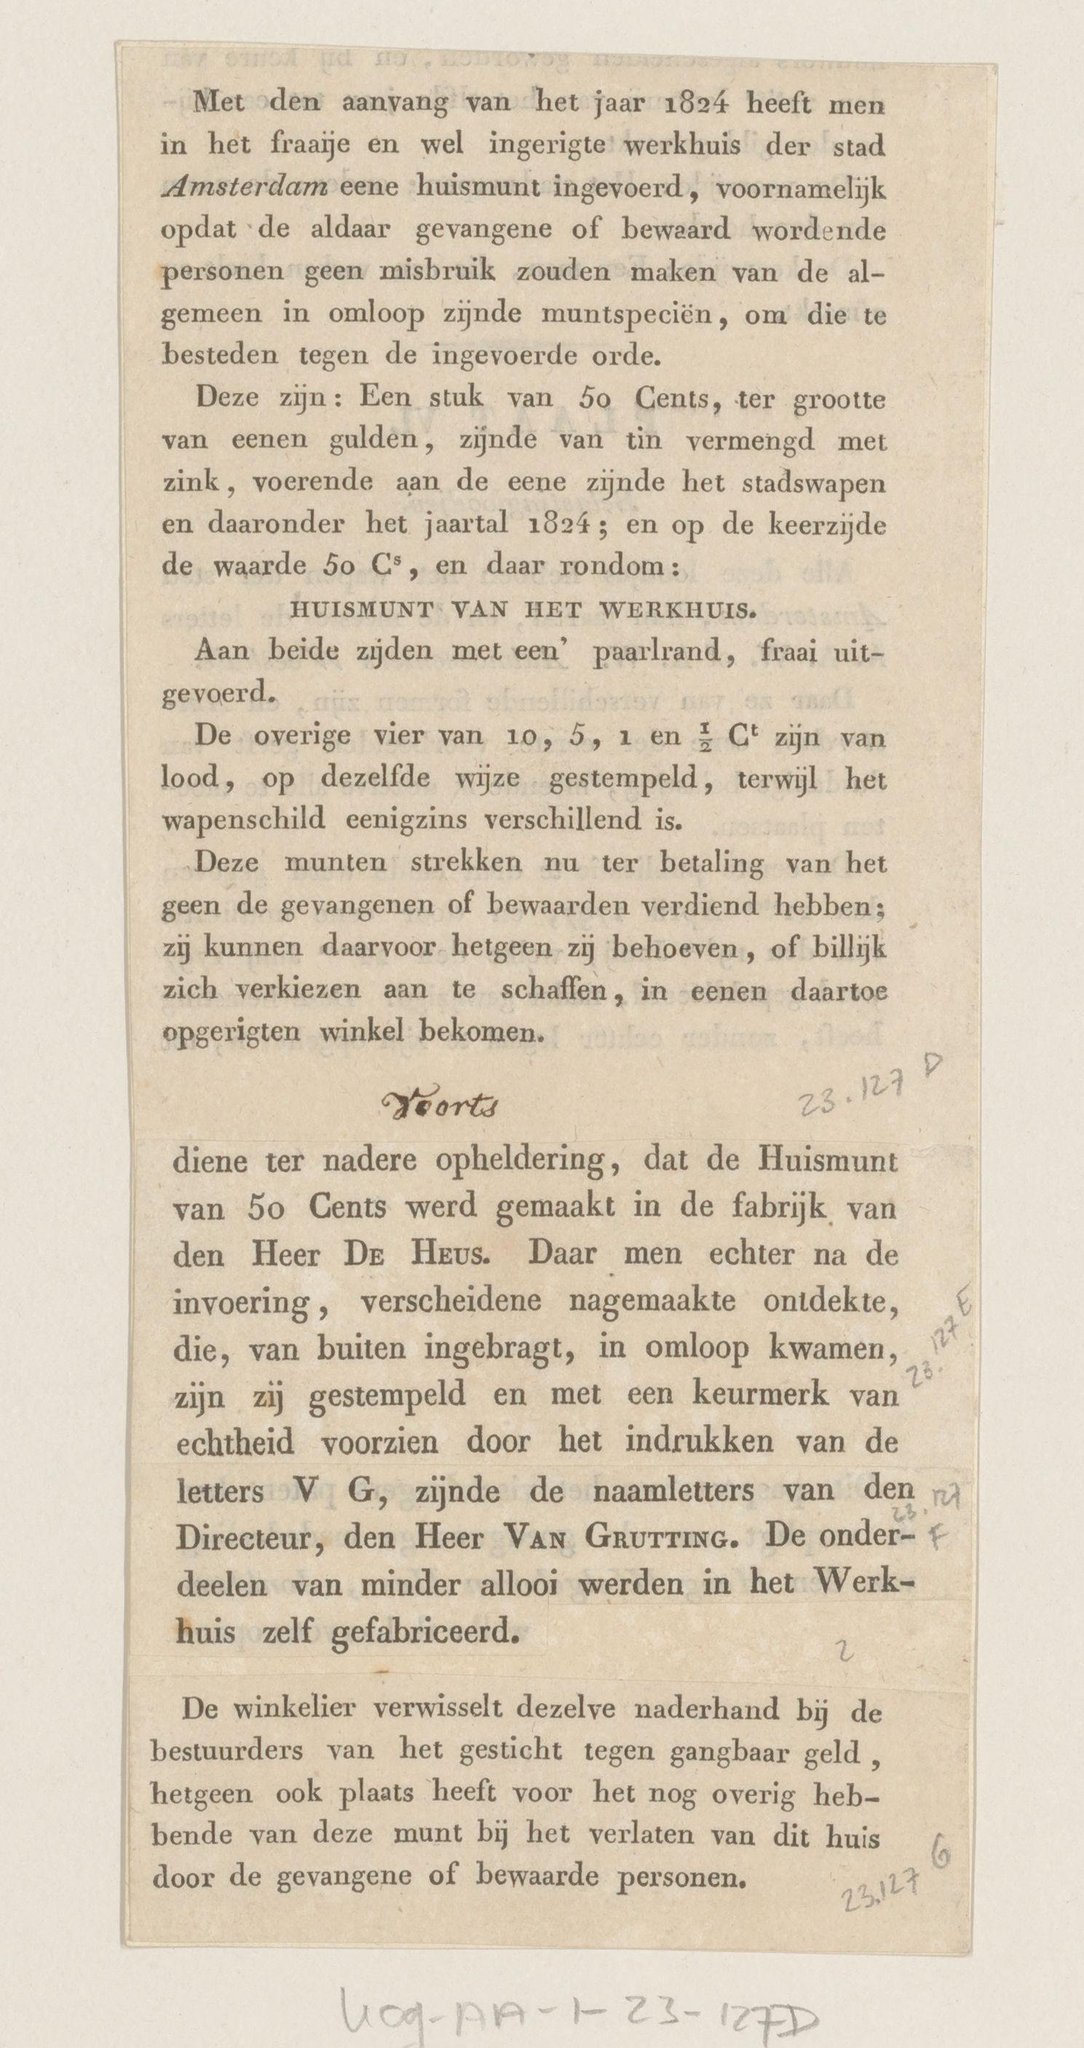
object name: text sheet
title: Tekst over de invoering van een munt in het Nieuwe Werkhuis te Amsterdam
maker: gerrit van orden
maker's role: mayor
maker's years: 1774-1854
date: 1830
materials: paper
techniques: letterpress printing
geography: zaandam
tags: prison, jail, coin, workhouse, penal camp, penitentiary, chain gang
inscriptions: collector's mark: Lugt 1641b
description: Tekst uit: Orden, Gerrit van. Bijdragen tot de Penningkunde (numismatiek) van het Koningrijk der Nederlanden. Zaandam: Jan Groot & Comp., 1830, p. 22-23, 43-44.